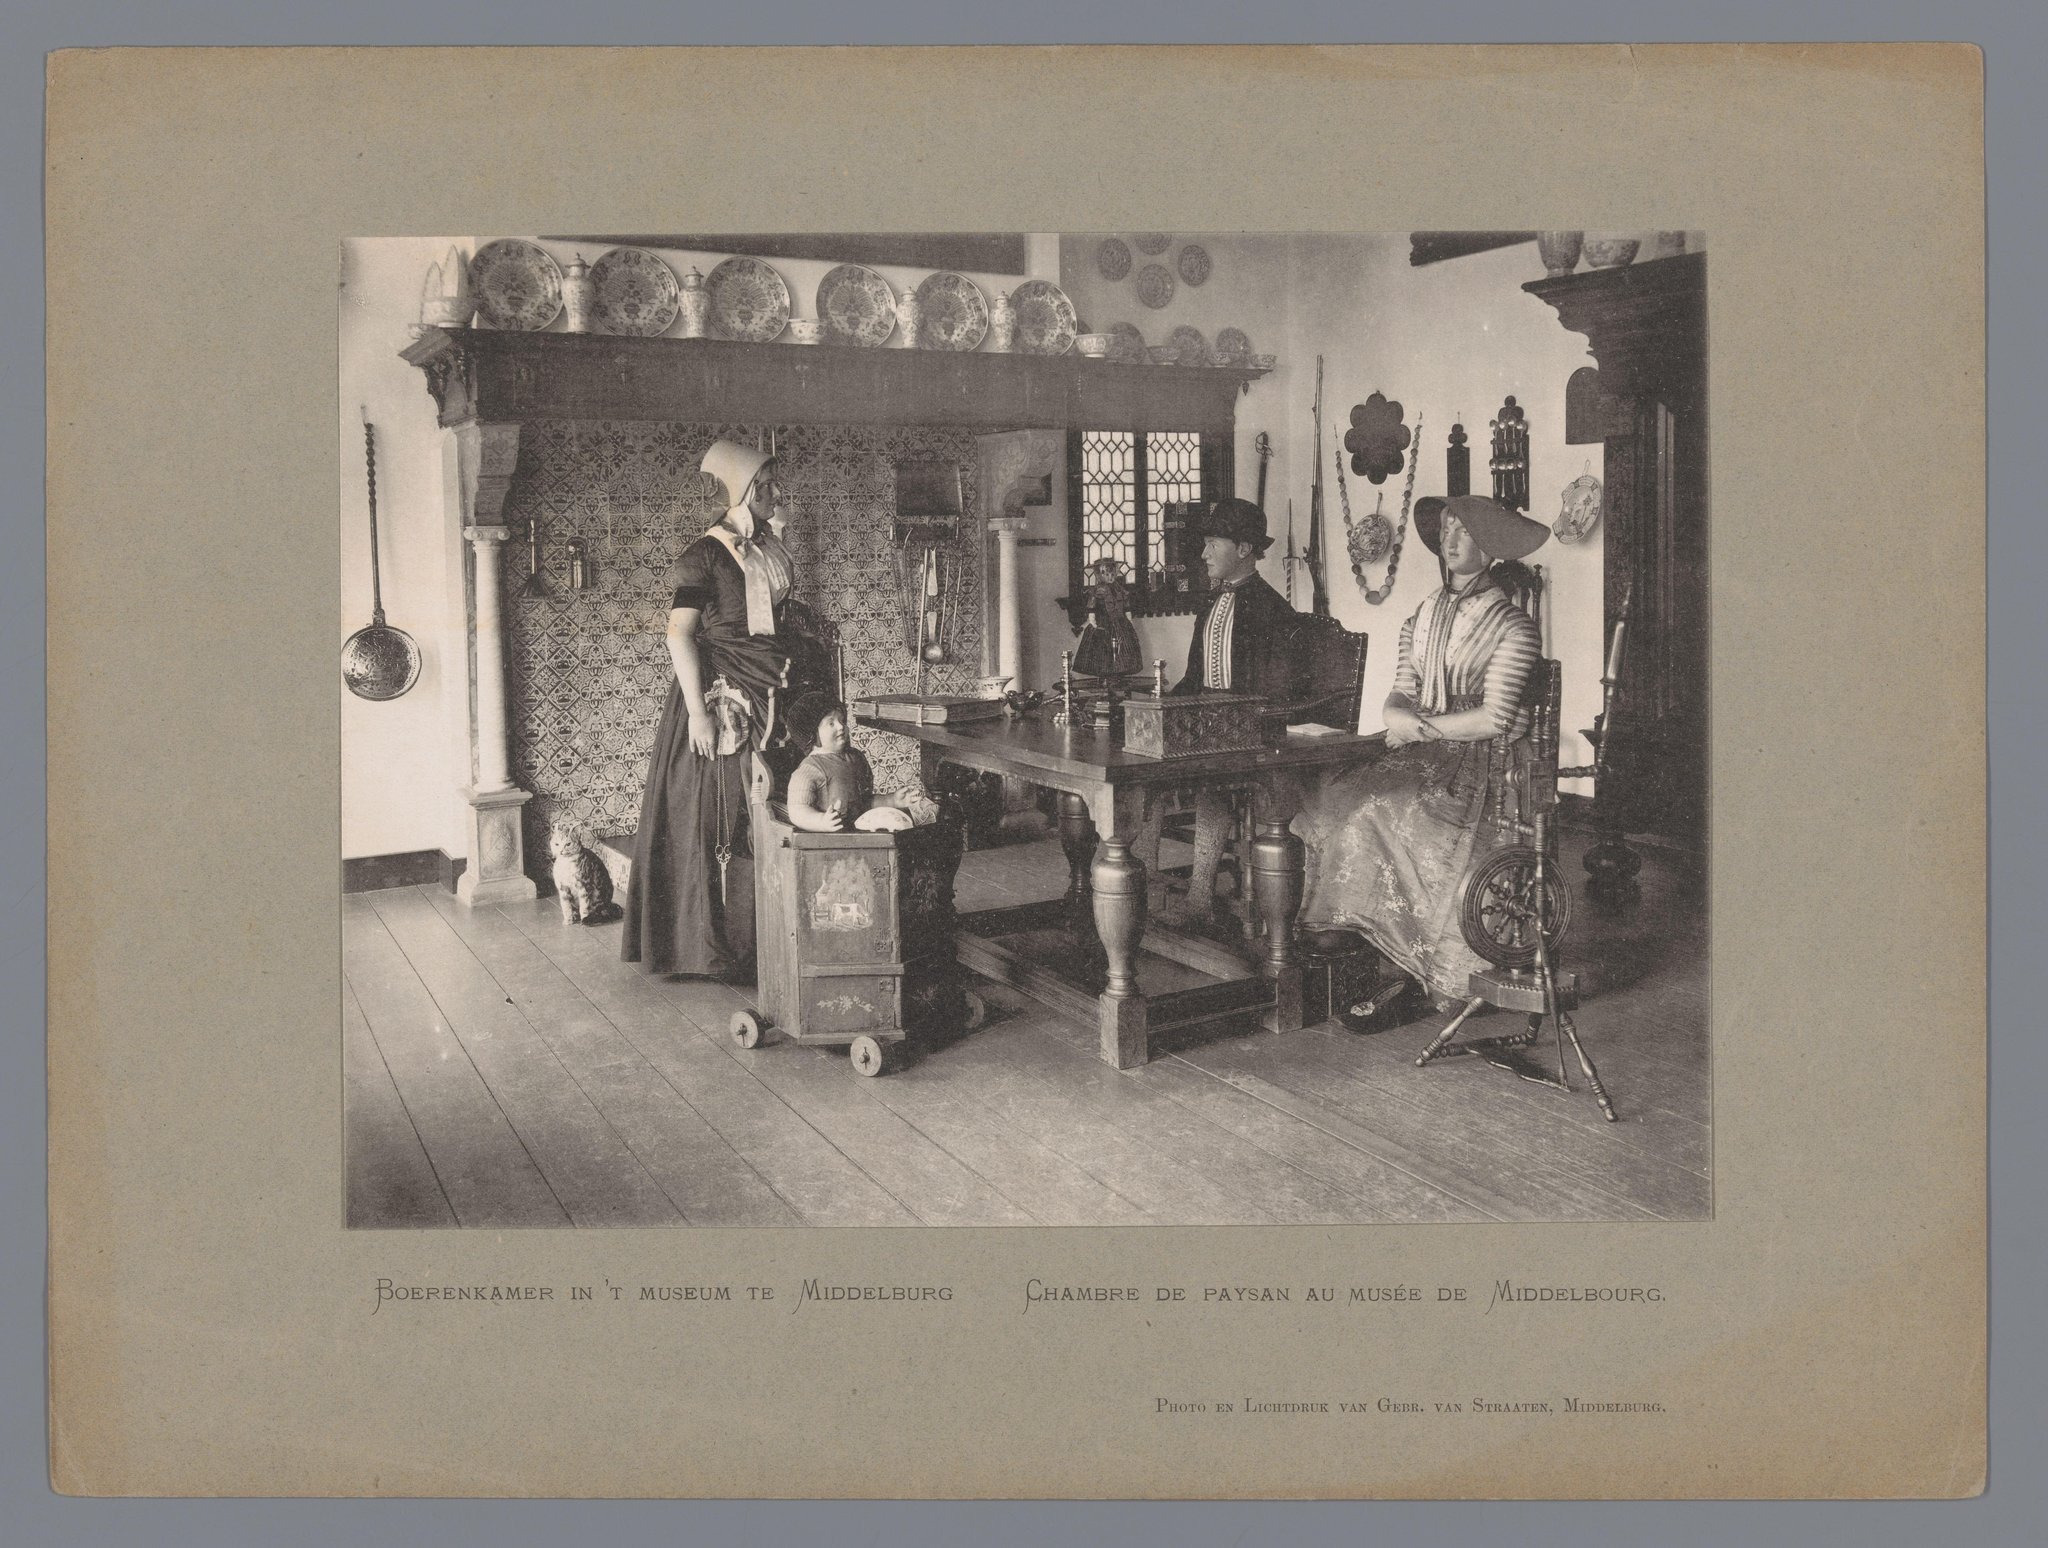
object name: photomechanical print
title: Boerenkamer in 't museum te Middelburg / Chambre de Paysan au musée de Middelbourg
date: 1890-1910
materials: paper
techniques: photograph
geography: middelburg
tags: farmers, permanent exhibition, museum, folk costume, regional costume, middelburg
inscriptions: collector's mark: ‘Vosmaer’